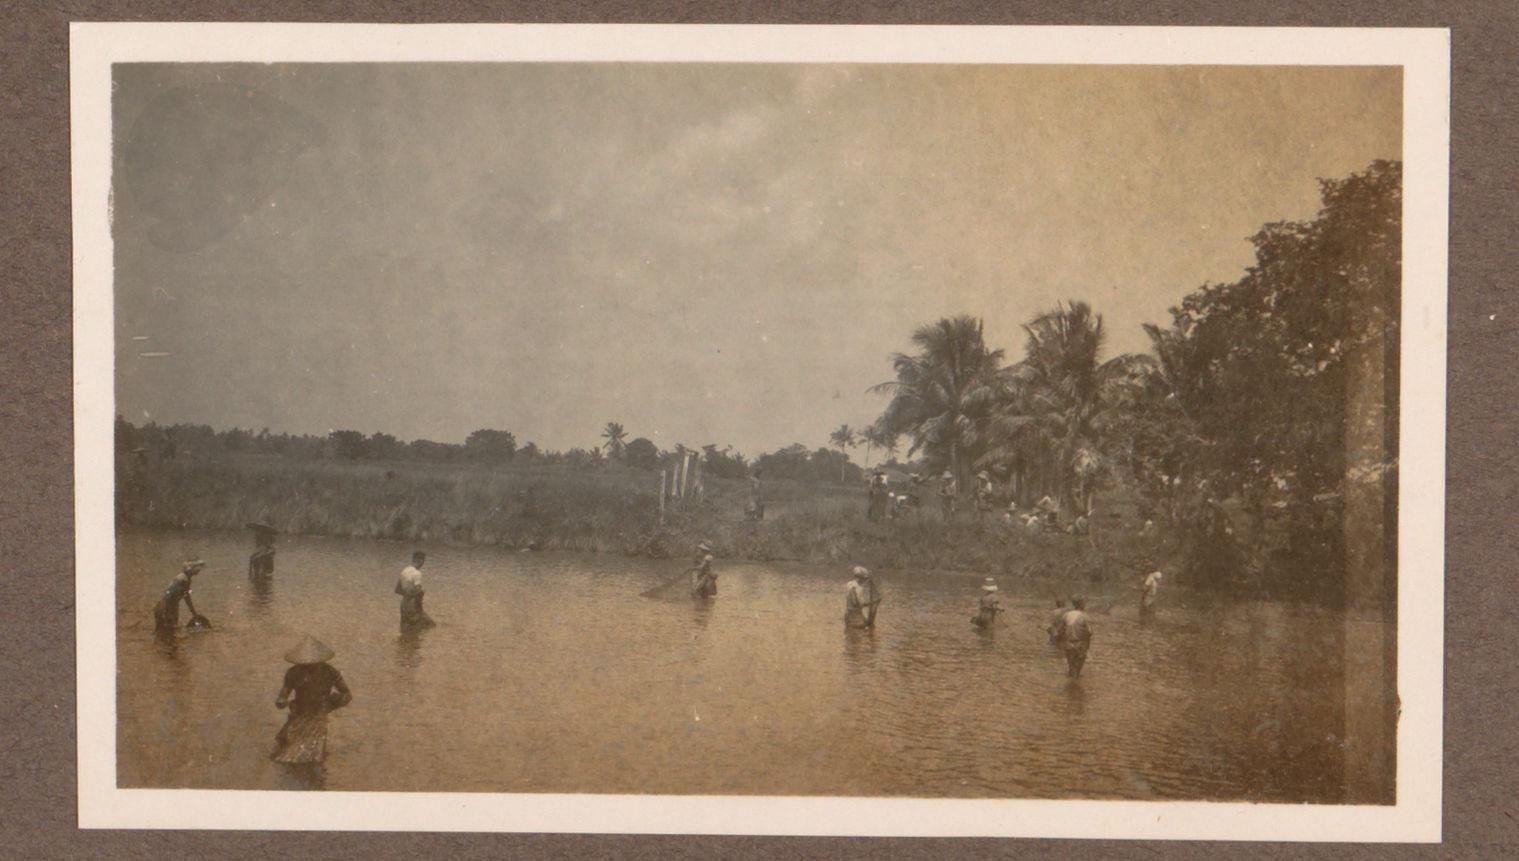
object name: photograph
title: Vissers staand in ondiep water in Nederlands-Indië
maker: klaas kleiterp (i)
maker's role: arts, officier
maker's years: 1892-1943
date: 1920-1930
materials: paper, photographic support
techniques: gelatin silver print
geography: dutch east indies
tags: fisherman, dutch east indies, the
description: Onderdeel van Fotoalbum van de familie Kleiterp-Vermeulen met opnames van Nederlands-Indië.